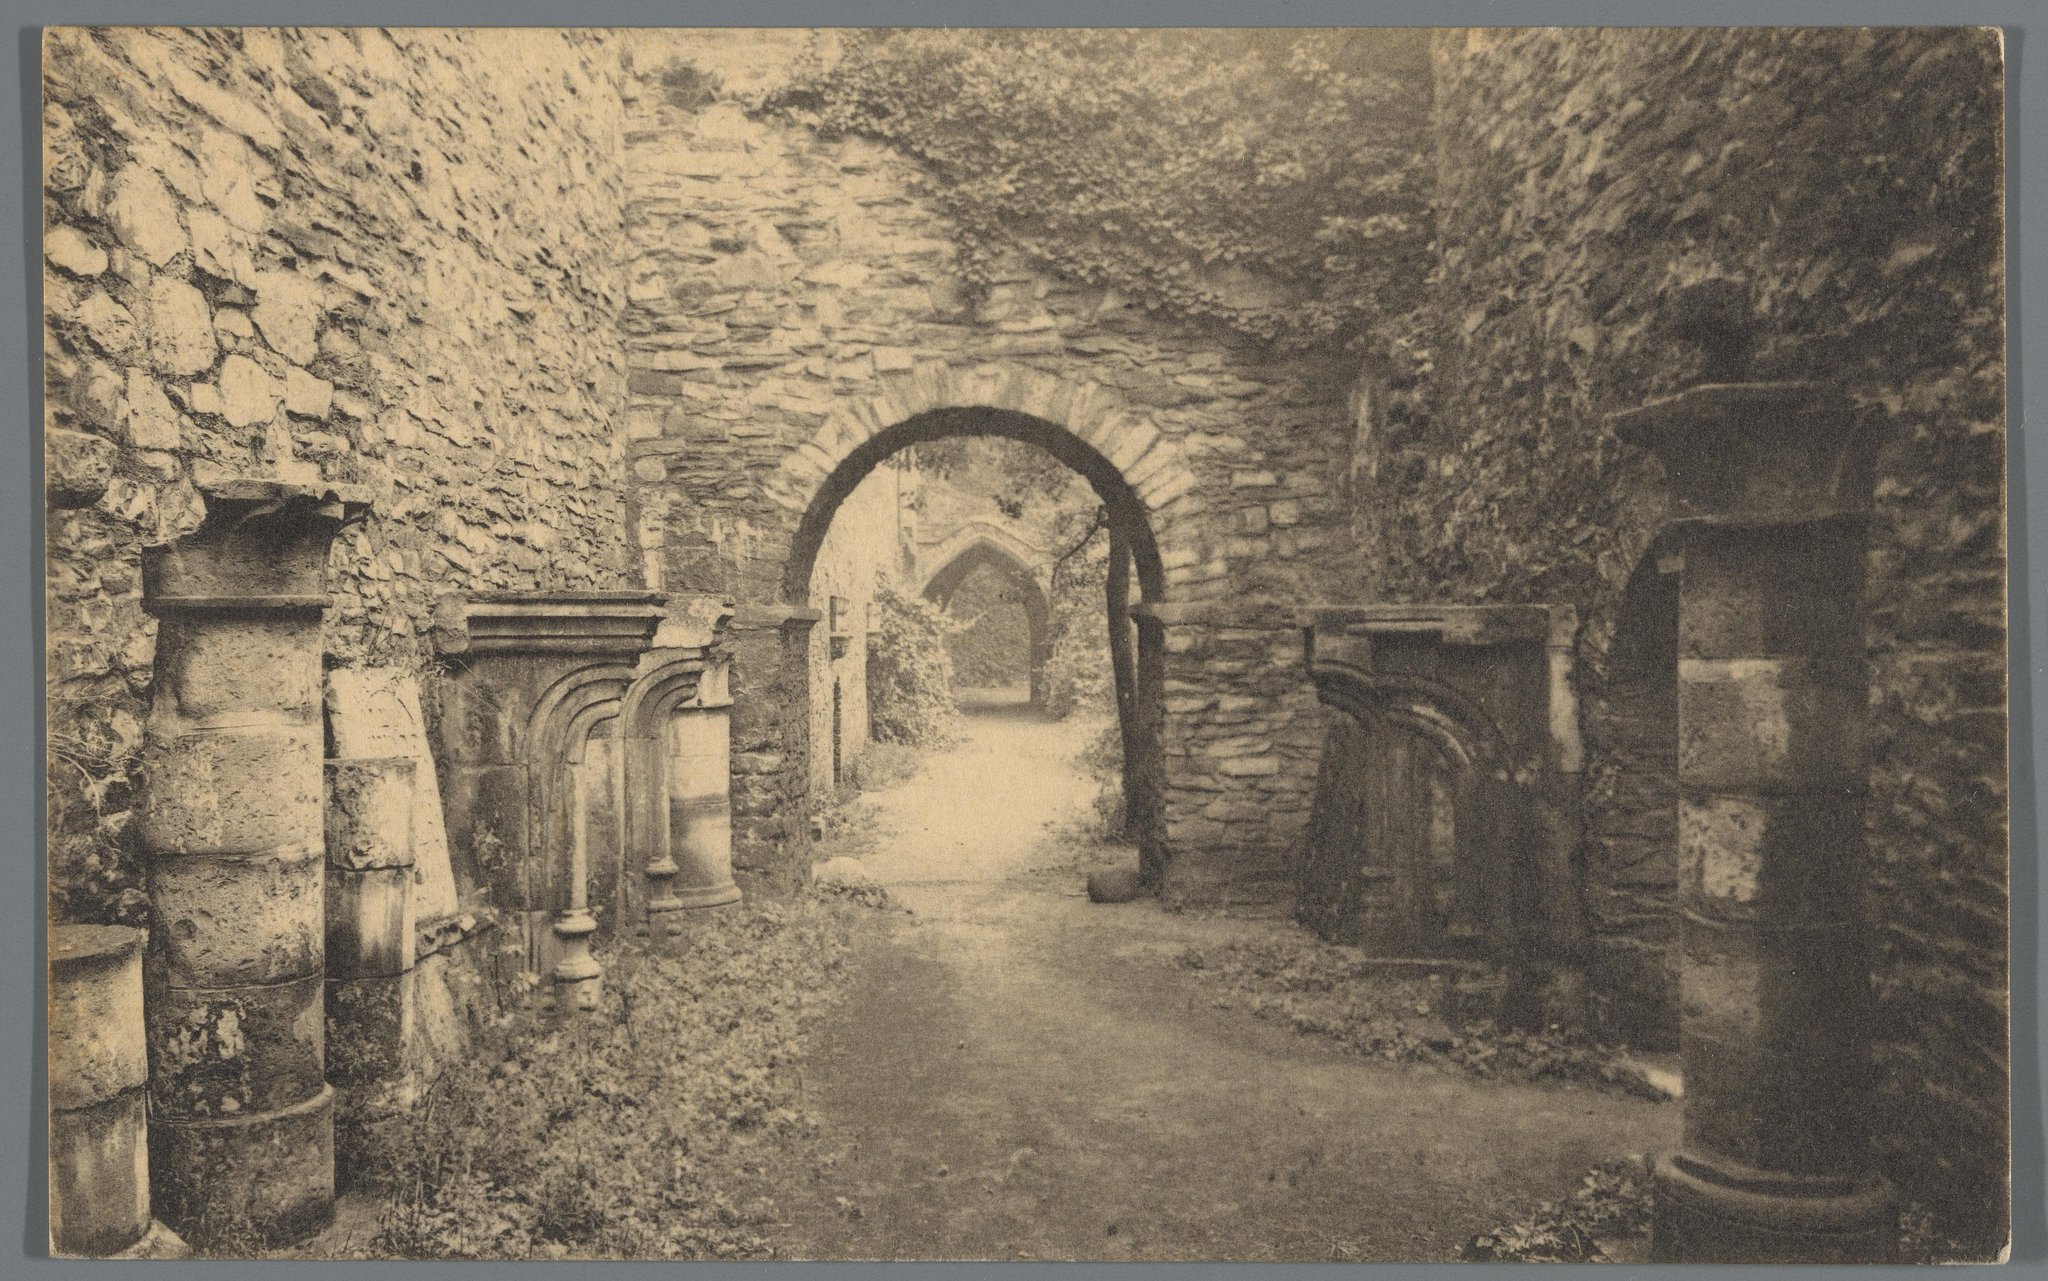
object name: postcard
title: Gand, Ruines de Saint - Bavon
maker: mme vanhooren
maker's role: fotograaf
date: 1920-1950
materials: photographic support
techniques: photograph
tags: ghent